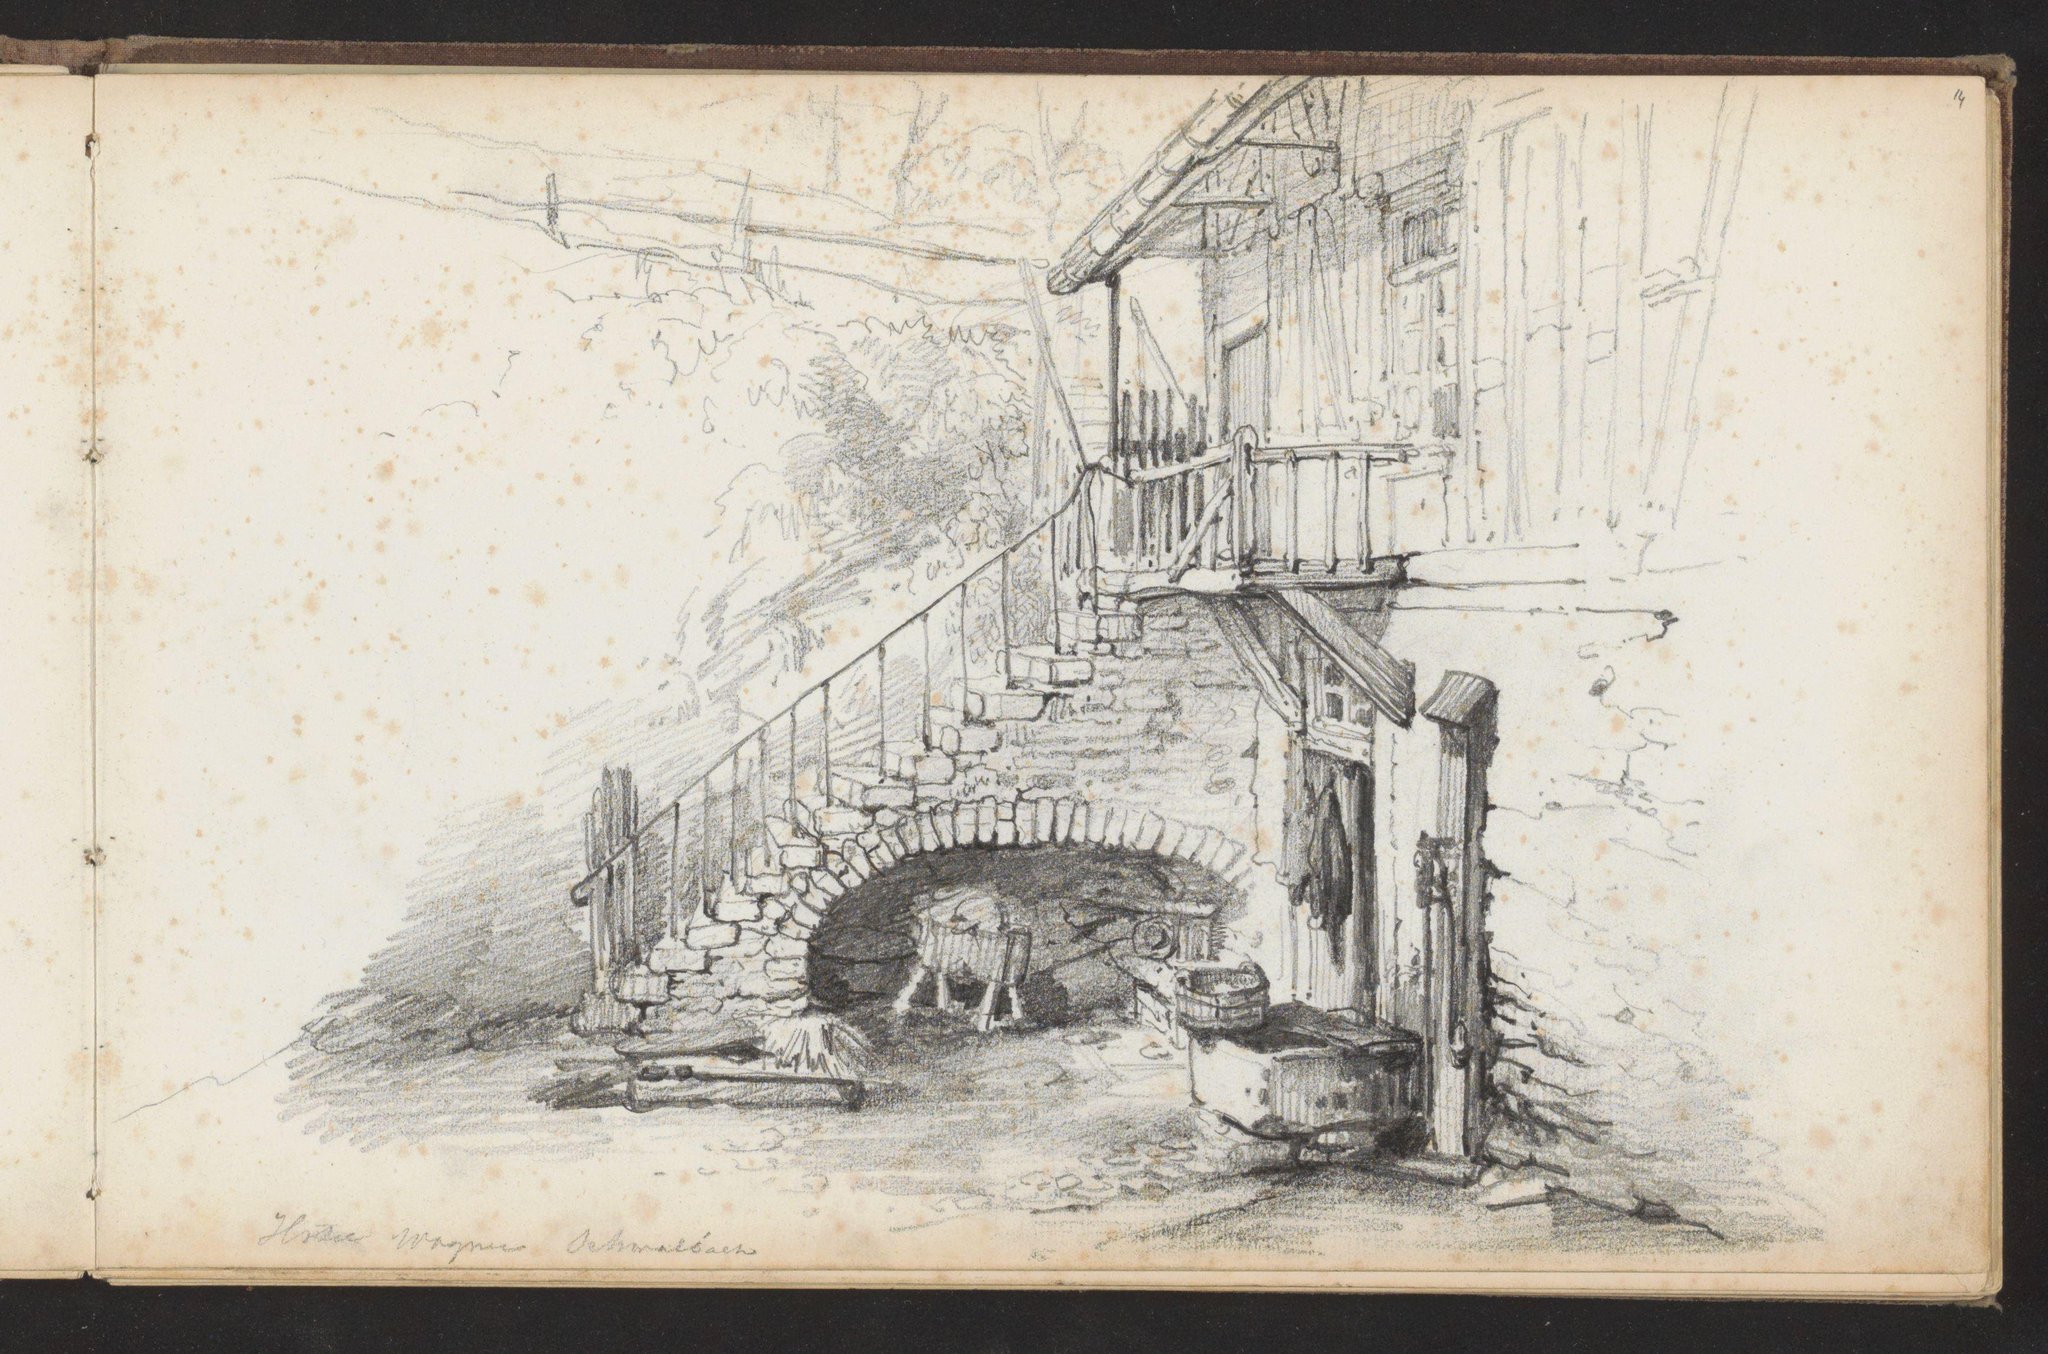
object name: sketchbook leaf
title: Binnenplaats met een trap naar een balkon aan de achterzijde van een huis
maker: maria vos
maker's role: draughtsman, painter, print maker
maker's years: 1824-1906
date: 1860-1865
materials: paper, pencil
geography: schwabach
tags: flight of steps, housing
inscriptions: annotation: ‘H[...]e Wagner Schwalbach’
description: Blad 14 recto uit een schetsboek met 55 bladen.